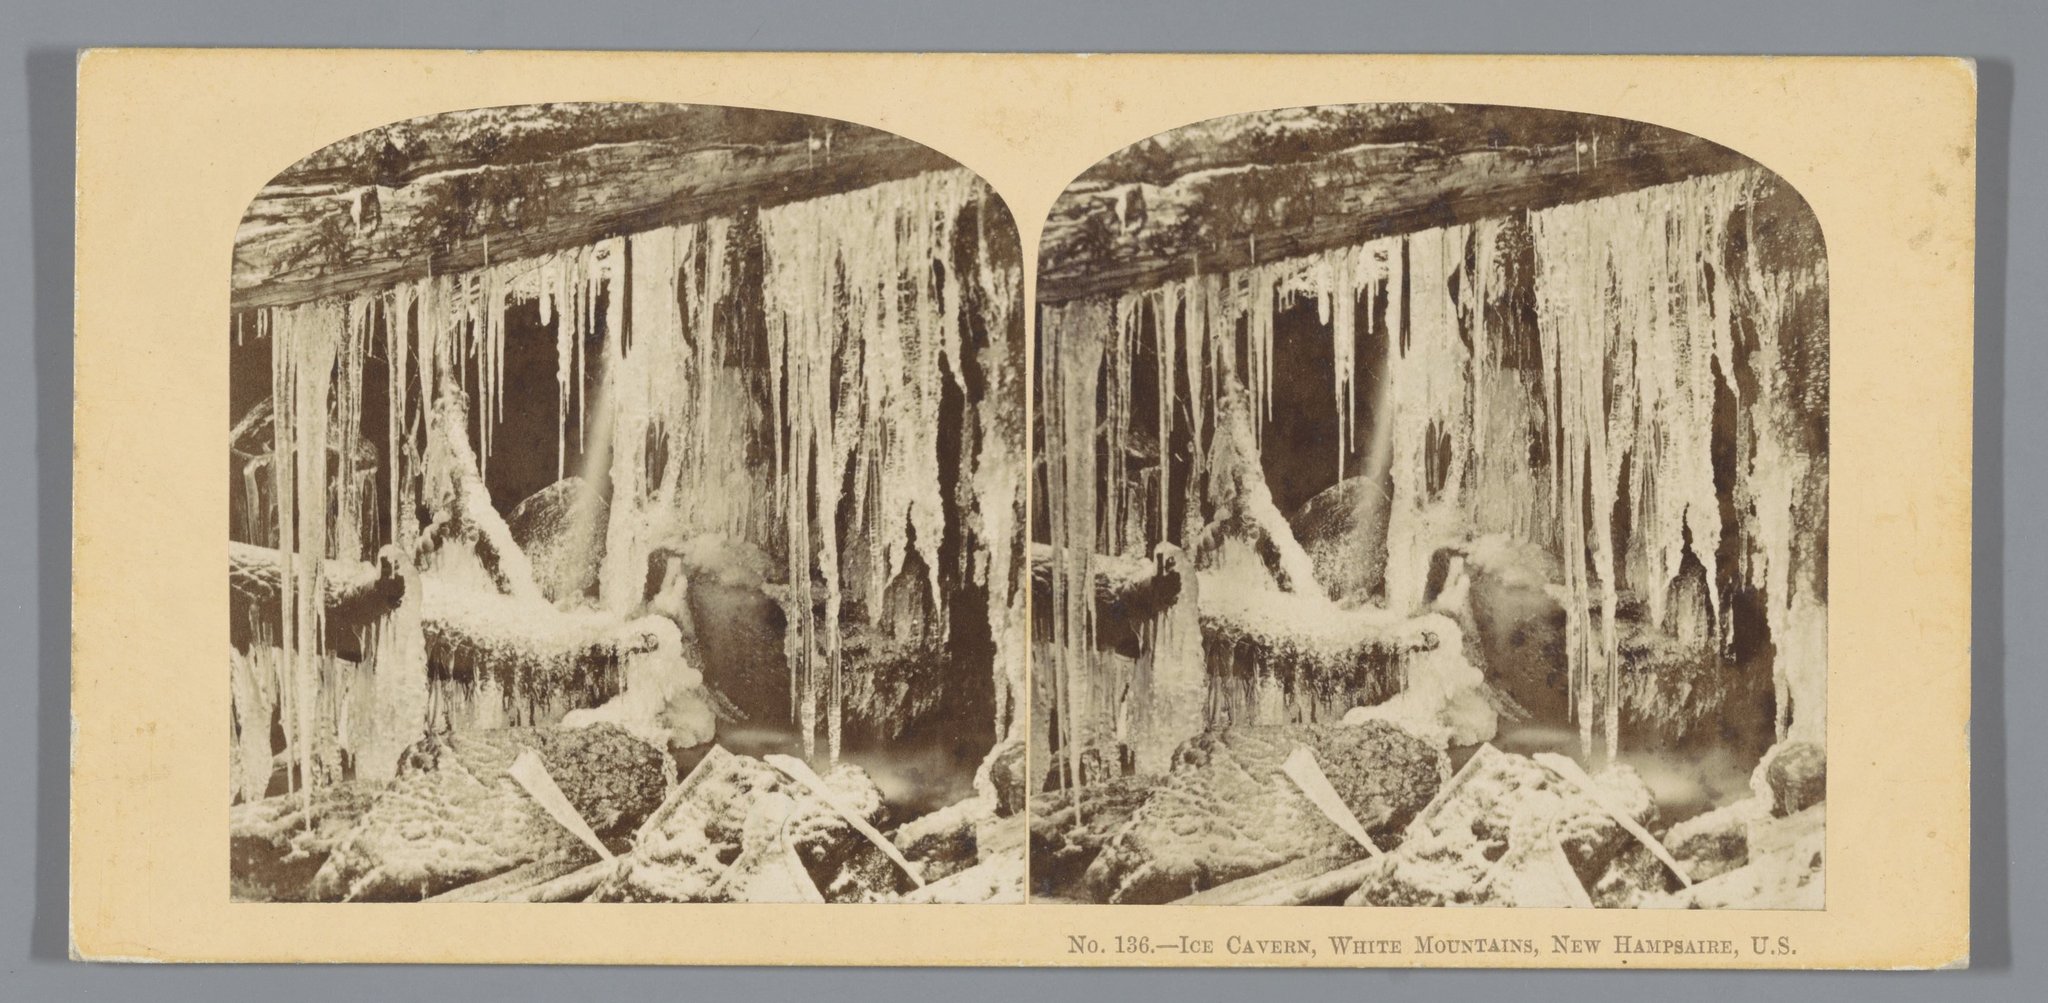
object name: stereograph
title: United States of America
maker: william england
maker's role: fotograaf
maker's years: 1816-1896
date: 1859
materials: cardboard, paper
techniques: albumen print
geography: white mountains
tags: stalactitic cave, icicle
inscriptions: number: ‘No. 136’, : ‘This group (...) therein." Bryant.’